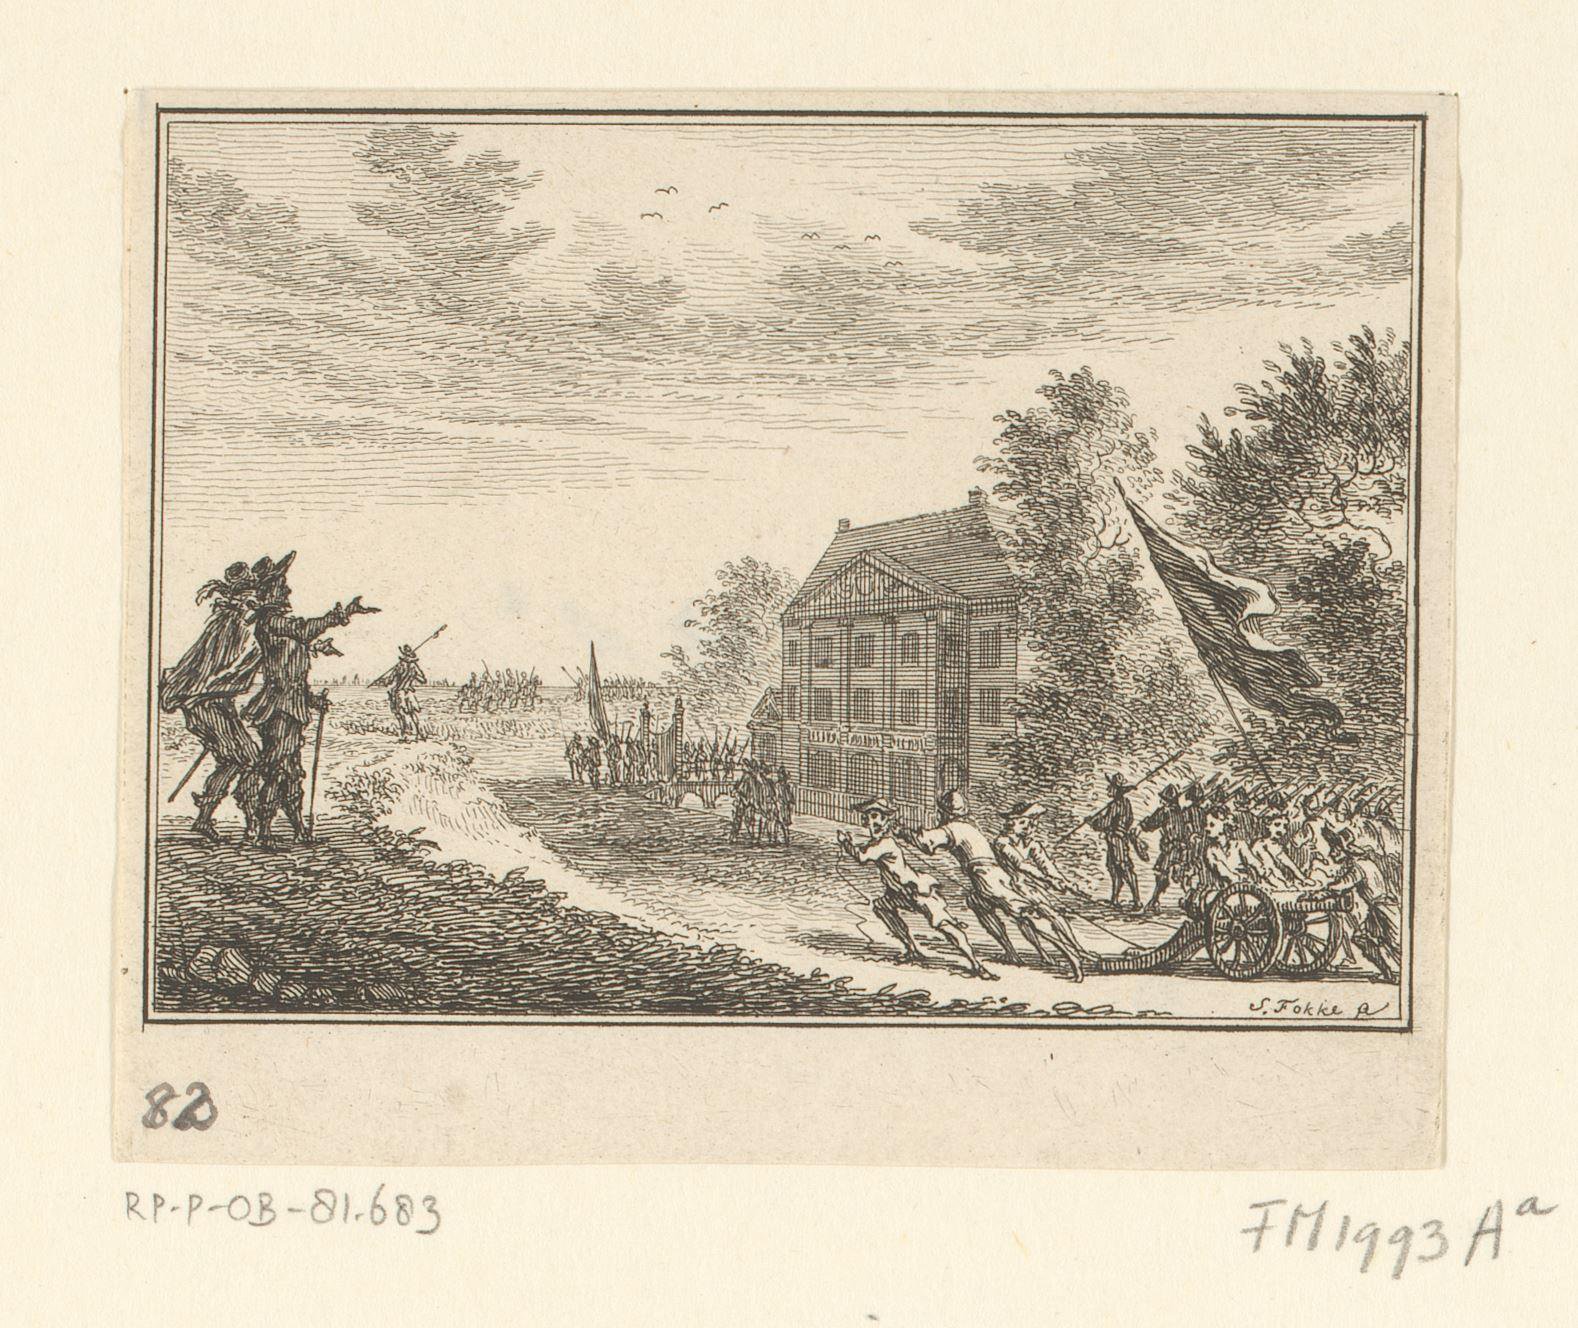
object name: history print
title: Aanslag van Willem II op Amsterdam, 1650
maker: simon fokke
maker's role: draughtsman, print maker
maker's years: 1712-1784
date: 1782-1784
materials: paper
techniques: etching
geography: northern netherlands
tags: arnhem, william ii (prince of orange), siege, position war, amsterdam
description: Gebruikt als illustratie in: J.W. te Water, De vaderlandsche Historie van den heere J. Wagenaar, verkort, en met leerzaame aanmerkingen, ten dienste der Nederlandsche jeugd, 1784-1800, 4 delen. Dit nummer is een door het RPK toegevoegd nummer en staat niet in Frederik Muller, het werk waar de prent voor is gemaakt of uit afkomstig is, staat wel vermeld in Frederik Muller. Mogelijk gebaseerd op de anonieme pret naar de tekening van R. Roghman van de troepen bij het Gemeenlandshuis van Rijnland in Spaarndam (zie RP-P-OB-4253).